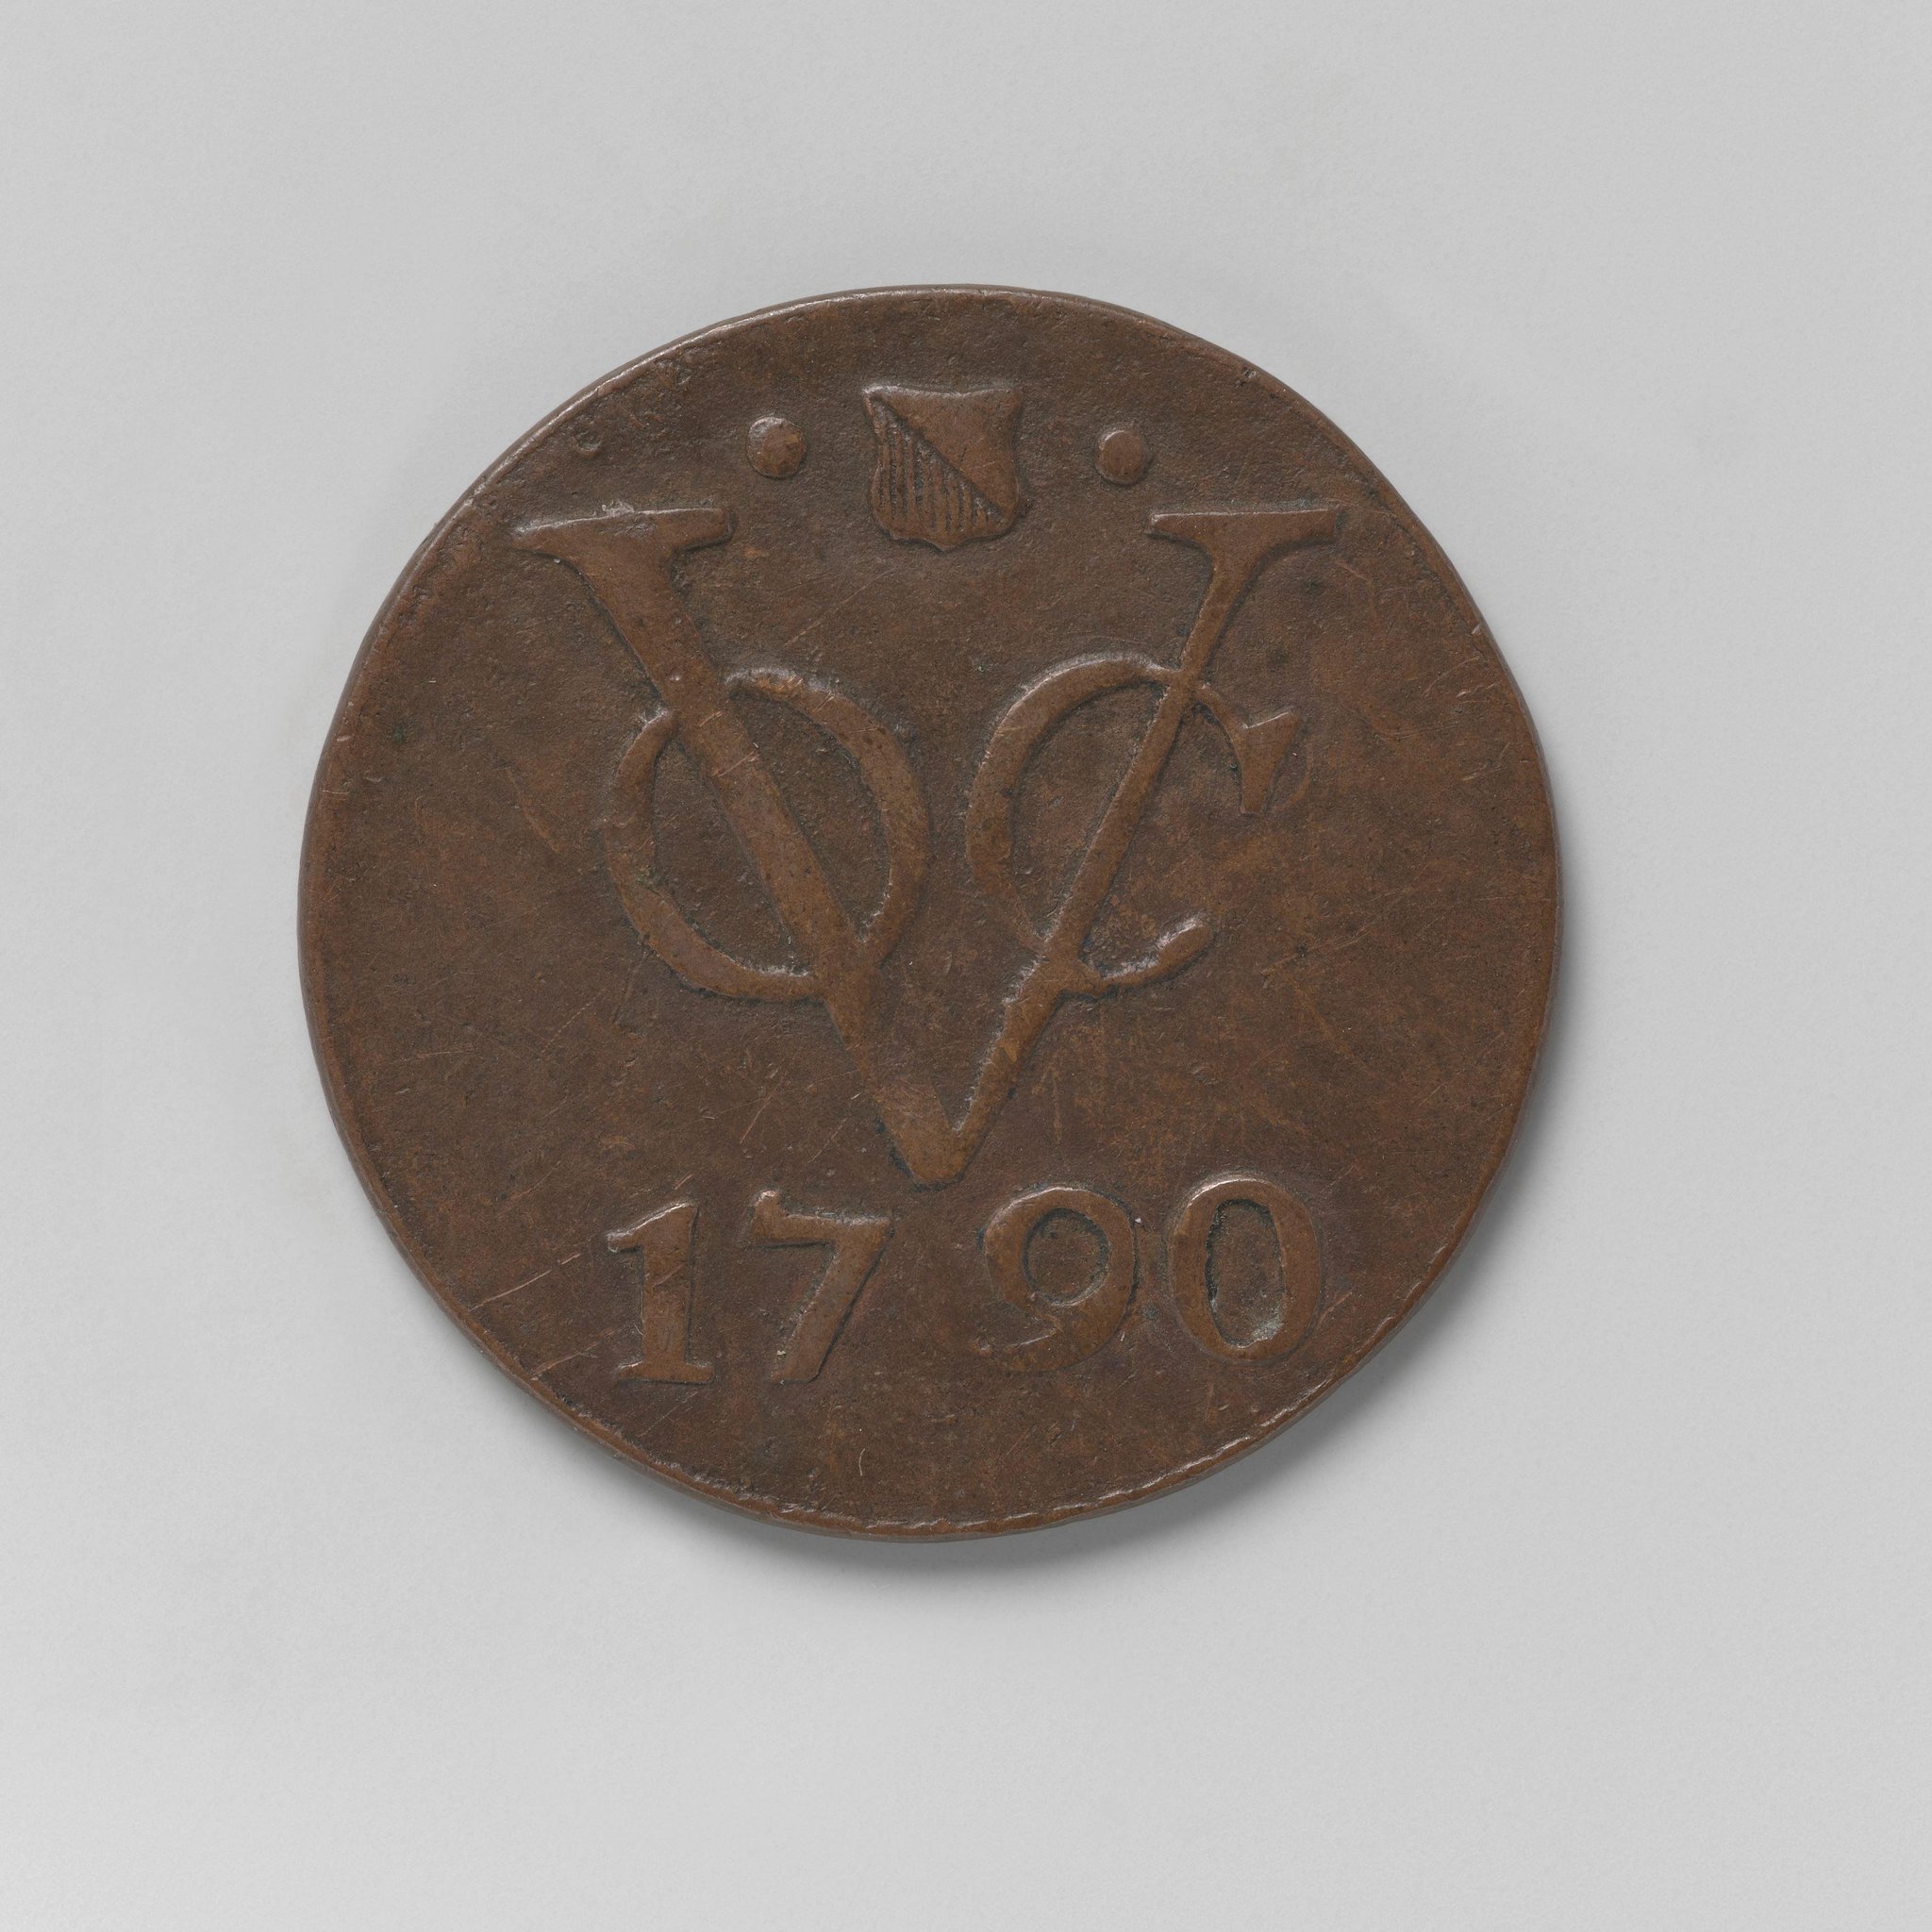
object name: coin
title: Duit van de VOC uit de stad Utrecht,1790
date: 1790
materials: copper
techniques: striking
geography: utrecht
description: Koperen munt. Voorzijde: op balk, waaronder guirlande, staand, door twee leeuwen gehouden gekroond wapenschild van de stad Utrecht. Keerzijde: monogram van de VOC, waarboven muntteken en waaronder jaartal. Gladde rand.